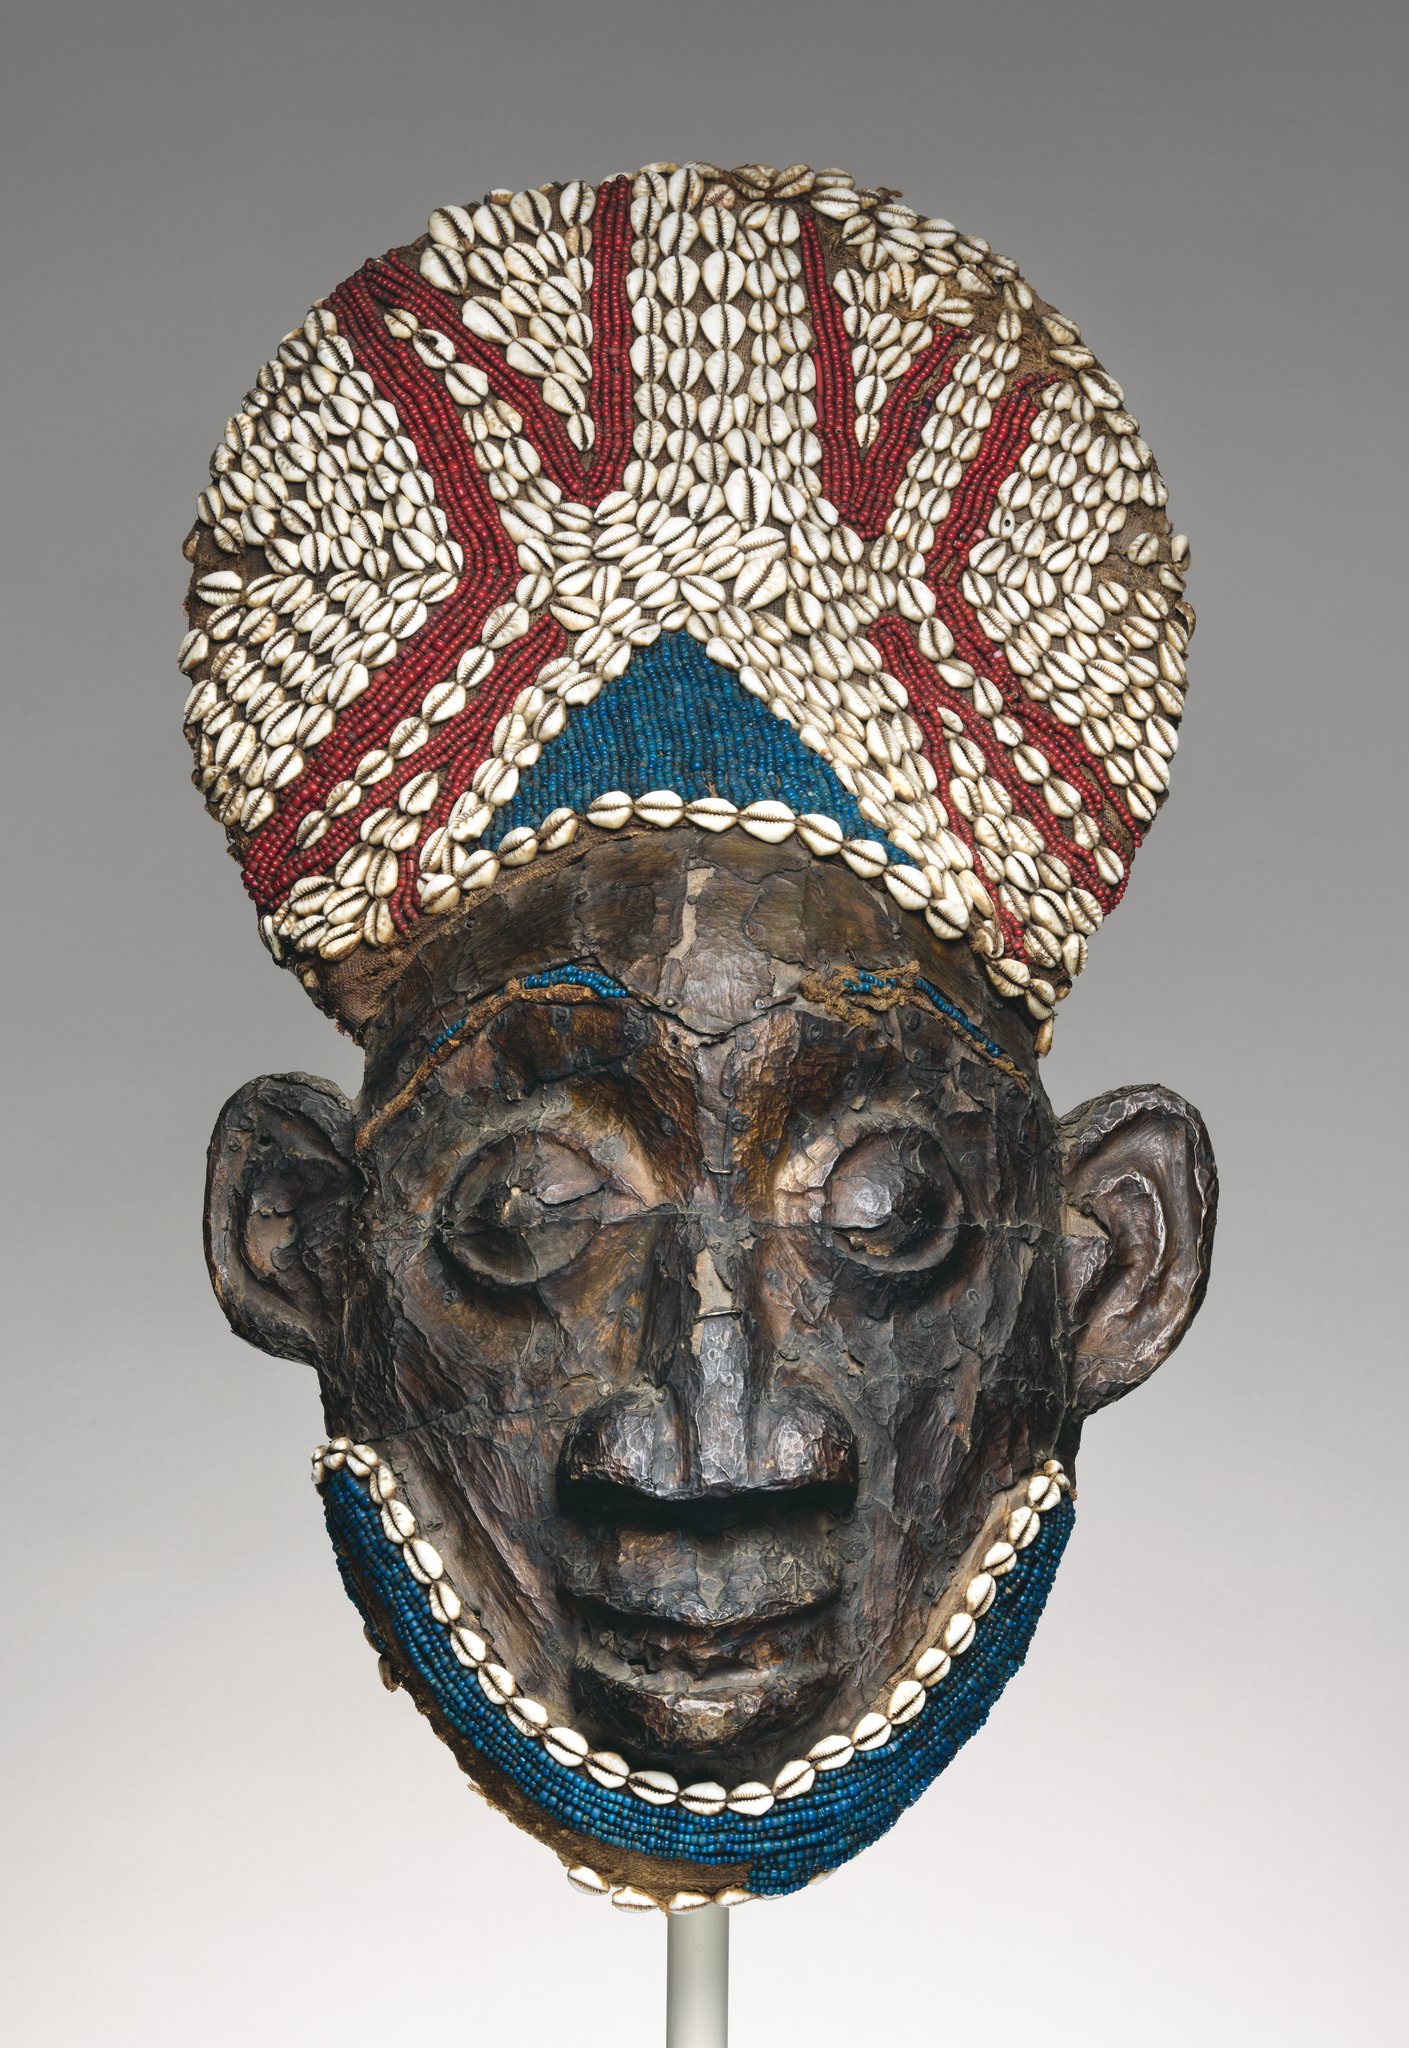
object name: mask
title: Helmet crest from a nja masquerade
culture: bamum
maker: grassfields artists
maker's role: artist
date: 1800-1880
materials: copper, glass, raffia, shell, wood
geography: cameroon